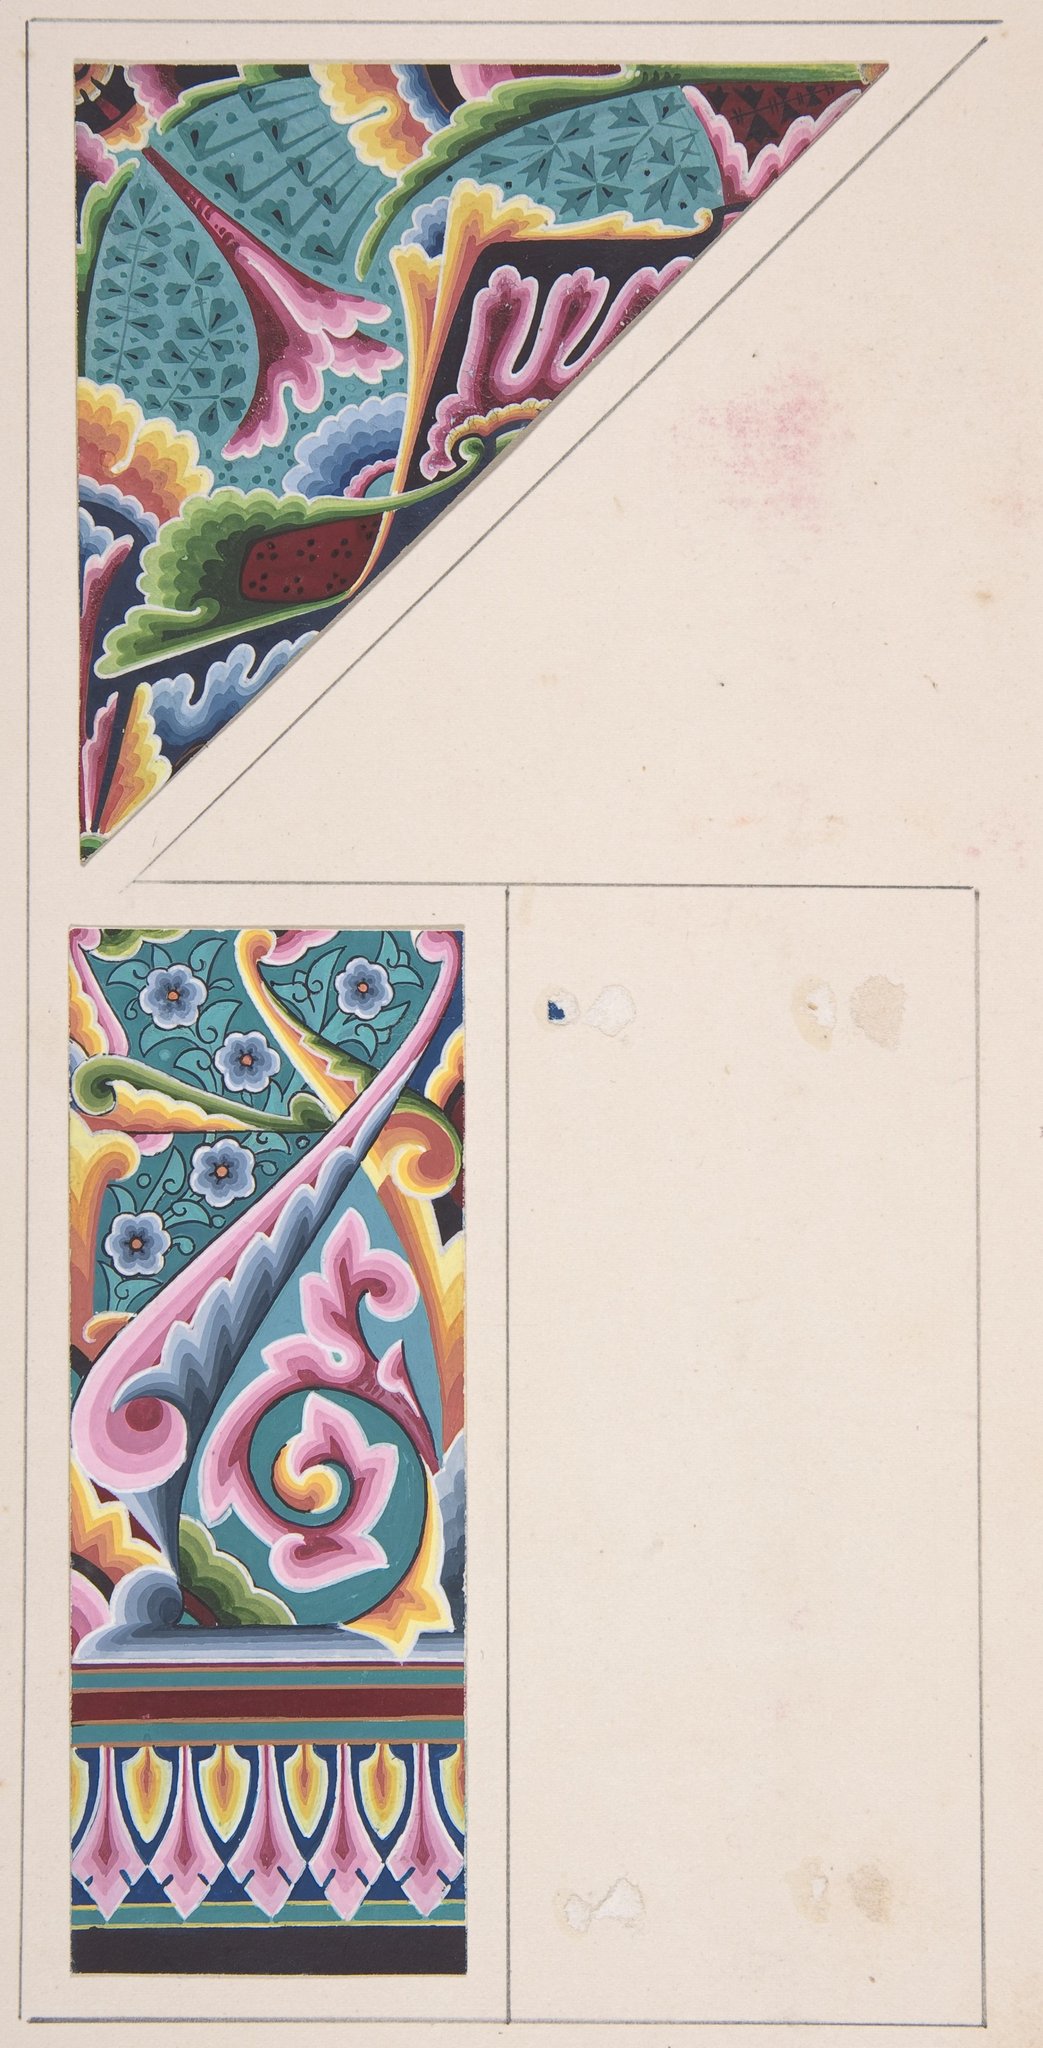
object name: drawing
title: Design drawing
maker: christopher dresser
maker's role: designer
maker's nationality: british, scottish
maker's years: 1834-1904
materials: gouache, graphite, ink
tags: flowers,abstraction